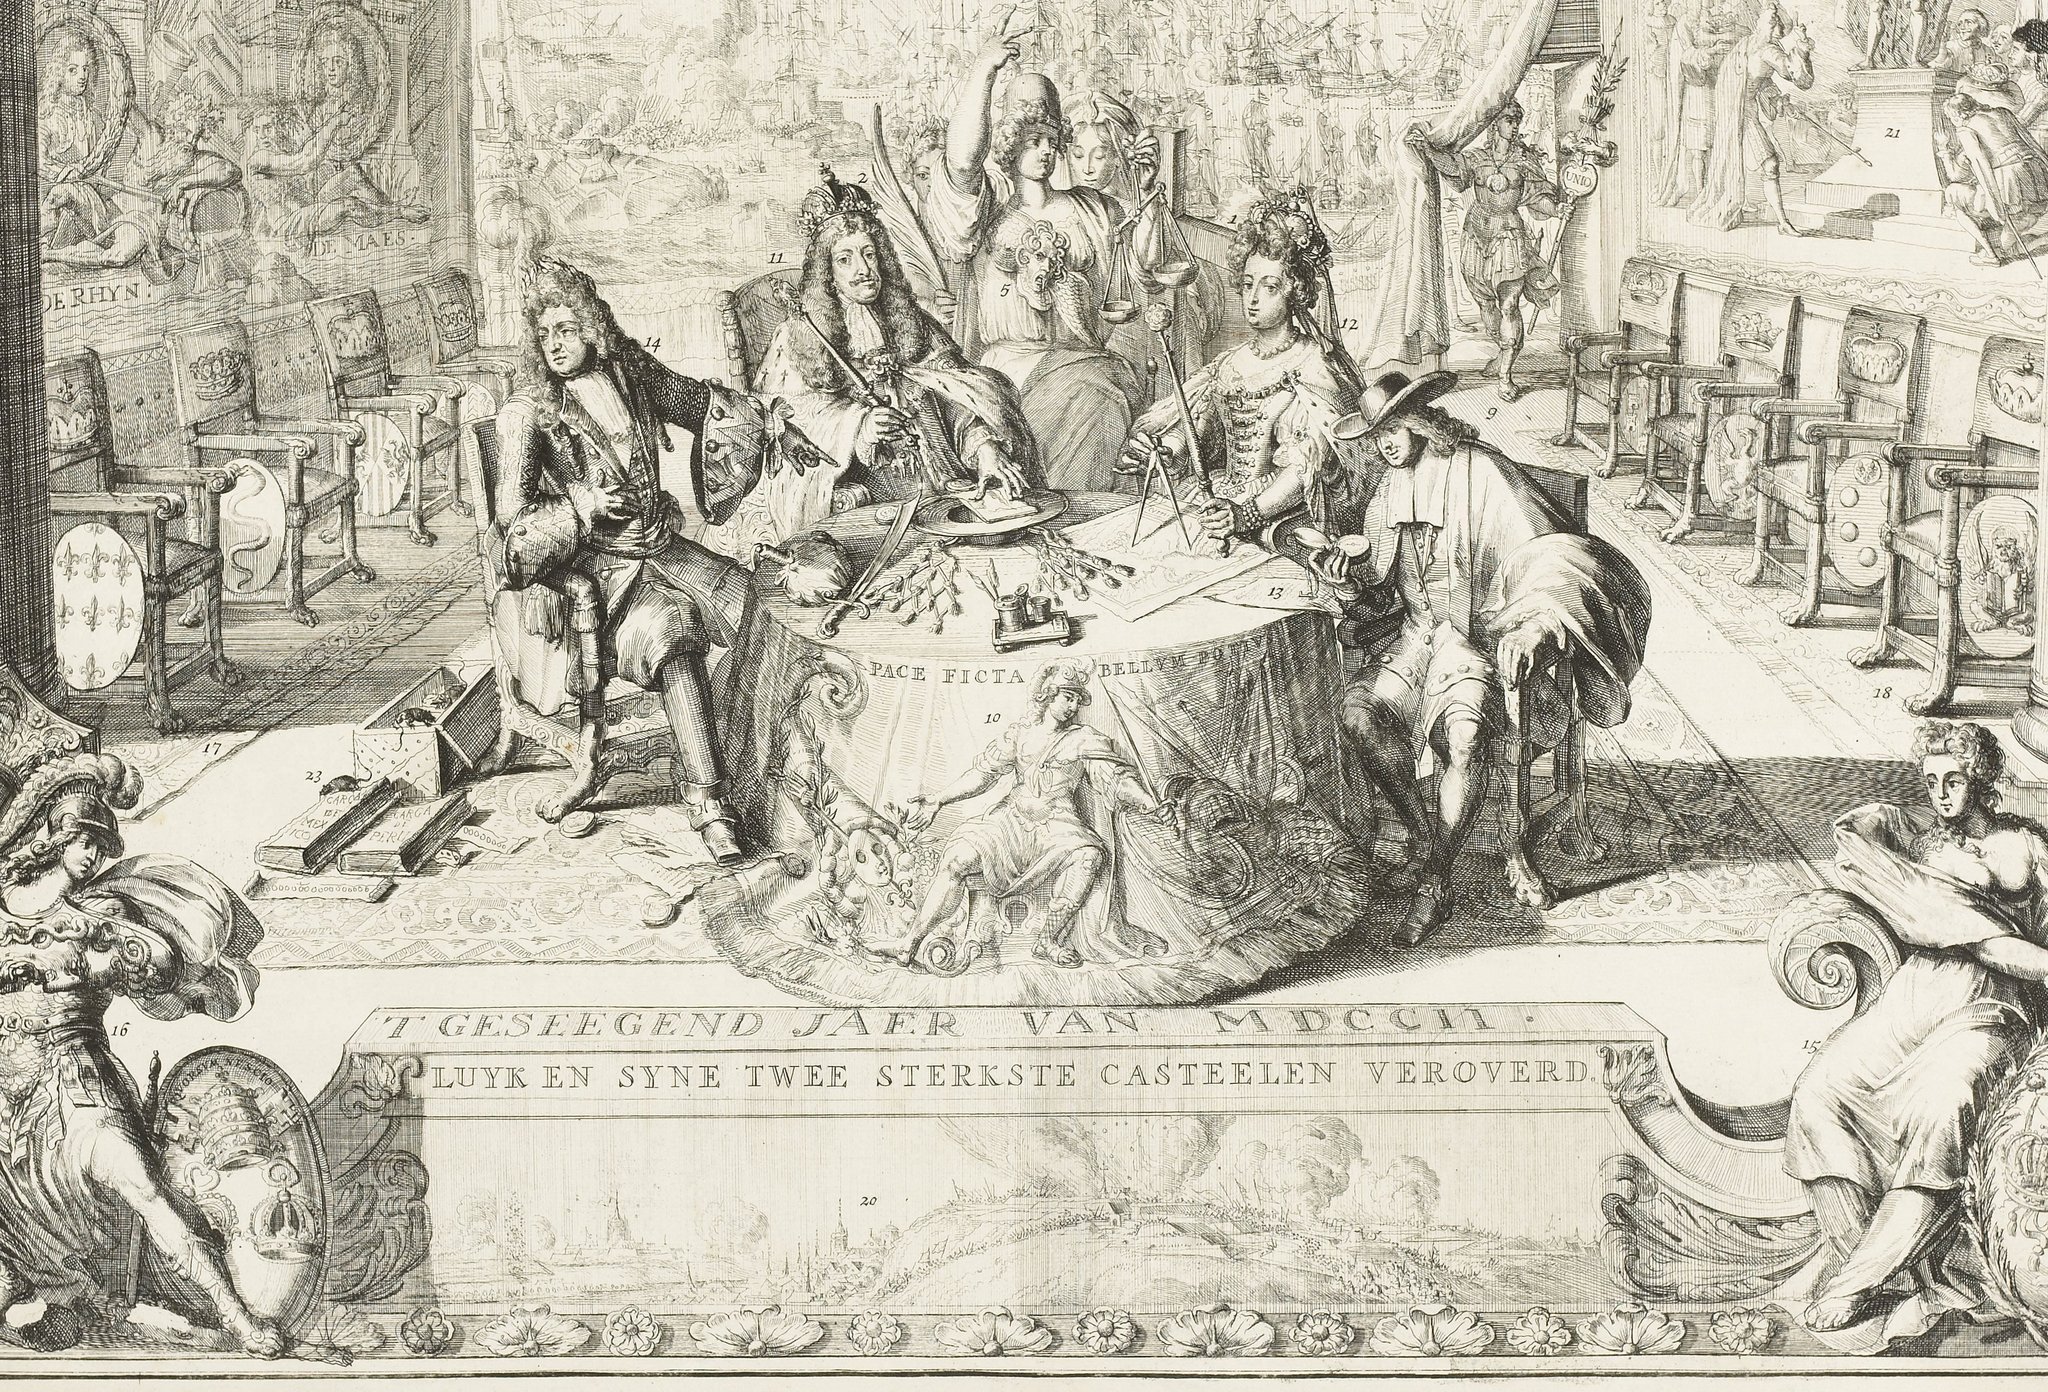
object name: propagandaprent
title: De Verbond-zaal der hoogst vermogende machten tot recht en vreede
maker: romeyn de hooghe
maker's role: draughtsman, goldsmith, painter, print maker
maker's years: 1645-1708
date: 1702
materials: paper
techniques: etching, letterpress printing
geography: northern netherlands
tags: lodewijk xiv (koning van frankrijk), leopold i (keizer van duitsland), karel ii (koning van spanje), london, anna stuart (koningin van engeland en schotland), fortitude, 'fortitudo' ~ one of the four cardinal virtues, prudence, 'prudentia'; 'prudenza' (ripa) ~ one of the four cardinal virtues, symbols, allegories of peace, 'pax'; 'pace' (ripa), the church personified, 'ecclesia', usually with chalice and banner, freedom, liberty; 'libertà' (ripa)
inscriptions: inscription: ‘DE VERBONDZAAL ... RECHT EN VREE.’, caption: ‘'T GESEEGEND JAER .../... CASTEELEN VEROVERD’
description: Allegorie op de politieke situatie in 1702 met een grote zaal waarin aan een ronde tafel de Duitse keizer, Koningin Anna en een lid der Hollandse Staten-Generaal zitten, naast koning Lodewijk XIV voor wie sabel op tafel ligt; de keizer haalt uit de kardinaalshoed van Porto Carrero het valse testament van Karel II. Achter de tafel staan de personificaties van Vrijheid, Vrede en Christendom. Op de achtergrond een wandtapijt met een afbeelding van de overwinning bij Vigo. Op de voorgrond Kracht en Voorzichtigheid bij een voorstelling van de verovering van Luik in 1702. Bij de prent behoort een los tekstblad waarop een verklaring van de cijfers 1-23 elk in 2 kolommen in Nederlands en Frans.